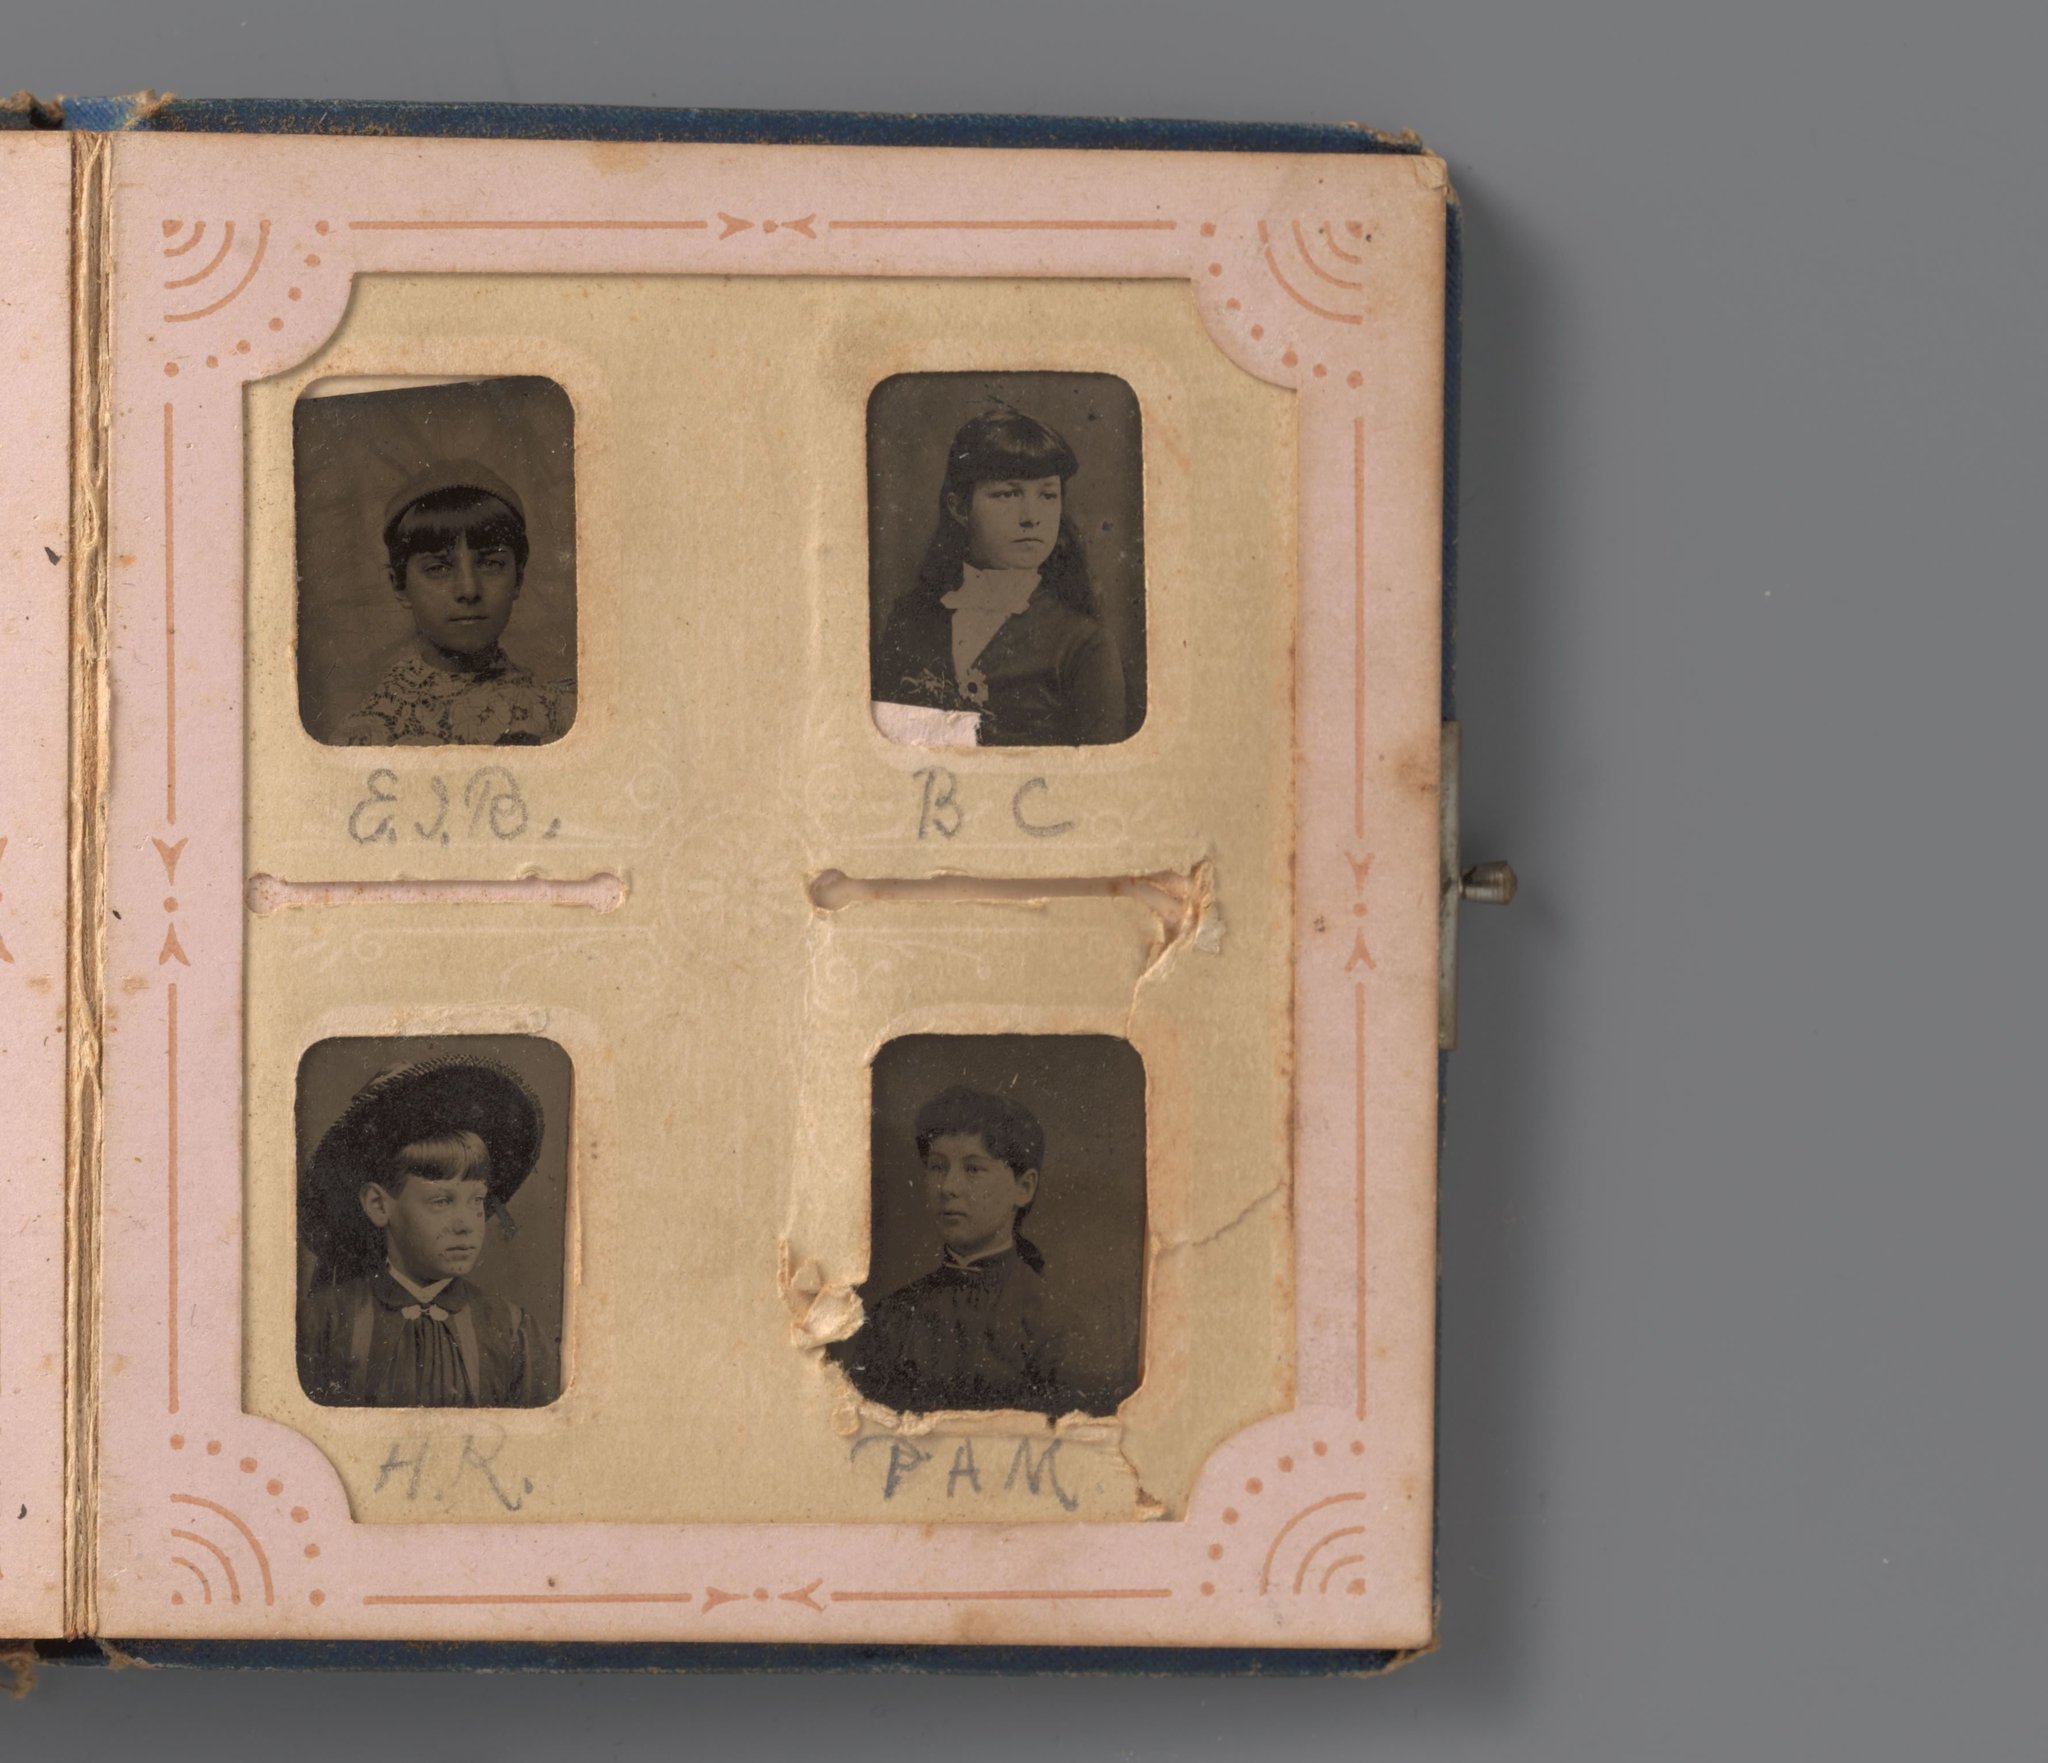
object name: photograph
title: Portretten van jonge vrouwen en een jonge man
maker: Anonymous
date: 1855-1940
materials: cardboard, iron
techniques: ferrotyping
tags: adolescent, young woman, maiden, historical persons - bb - woman, historical persons, youth, adolescent, head-gear: hat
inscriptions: monogram: ‘E.J.B.’, monogram: ‘P A M’, monogram: ‘B C’, monogram: ‘H.R.’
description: Deze foto's maken deel uit van een album.